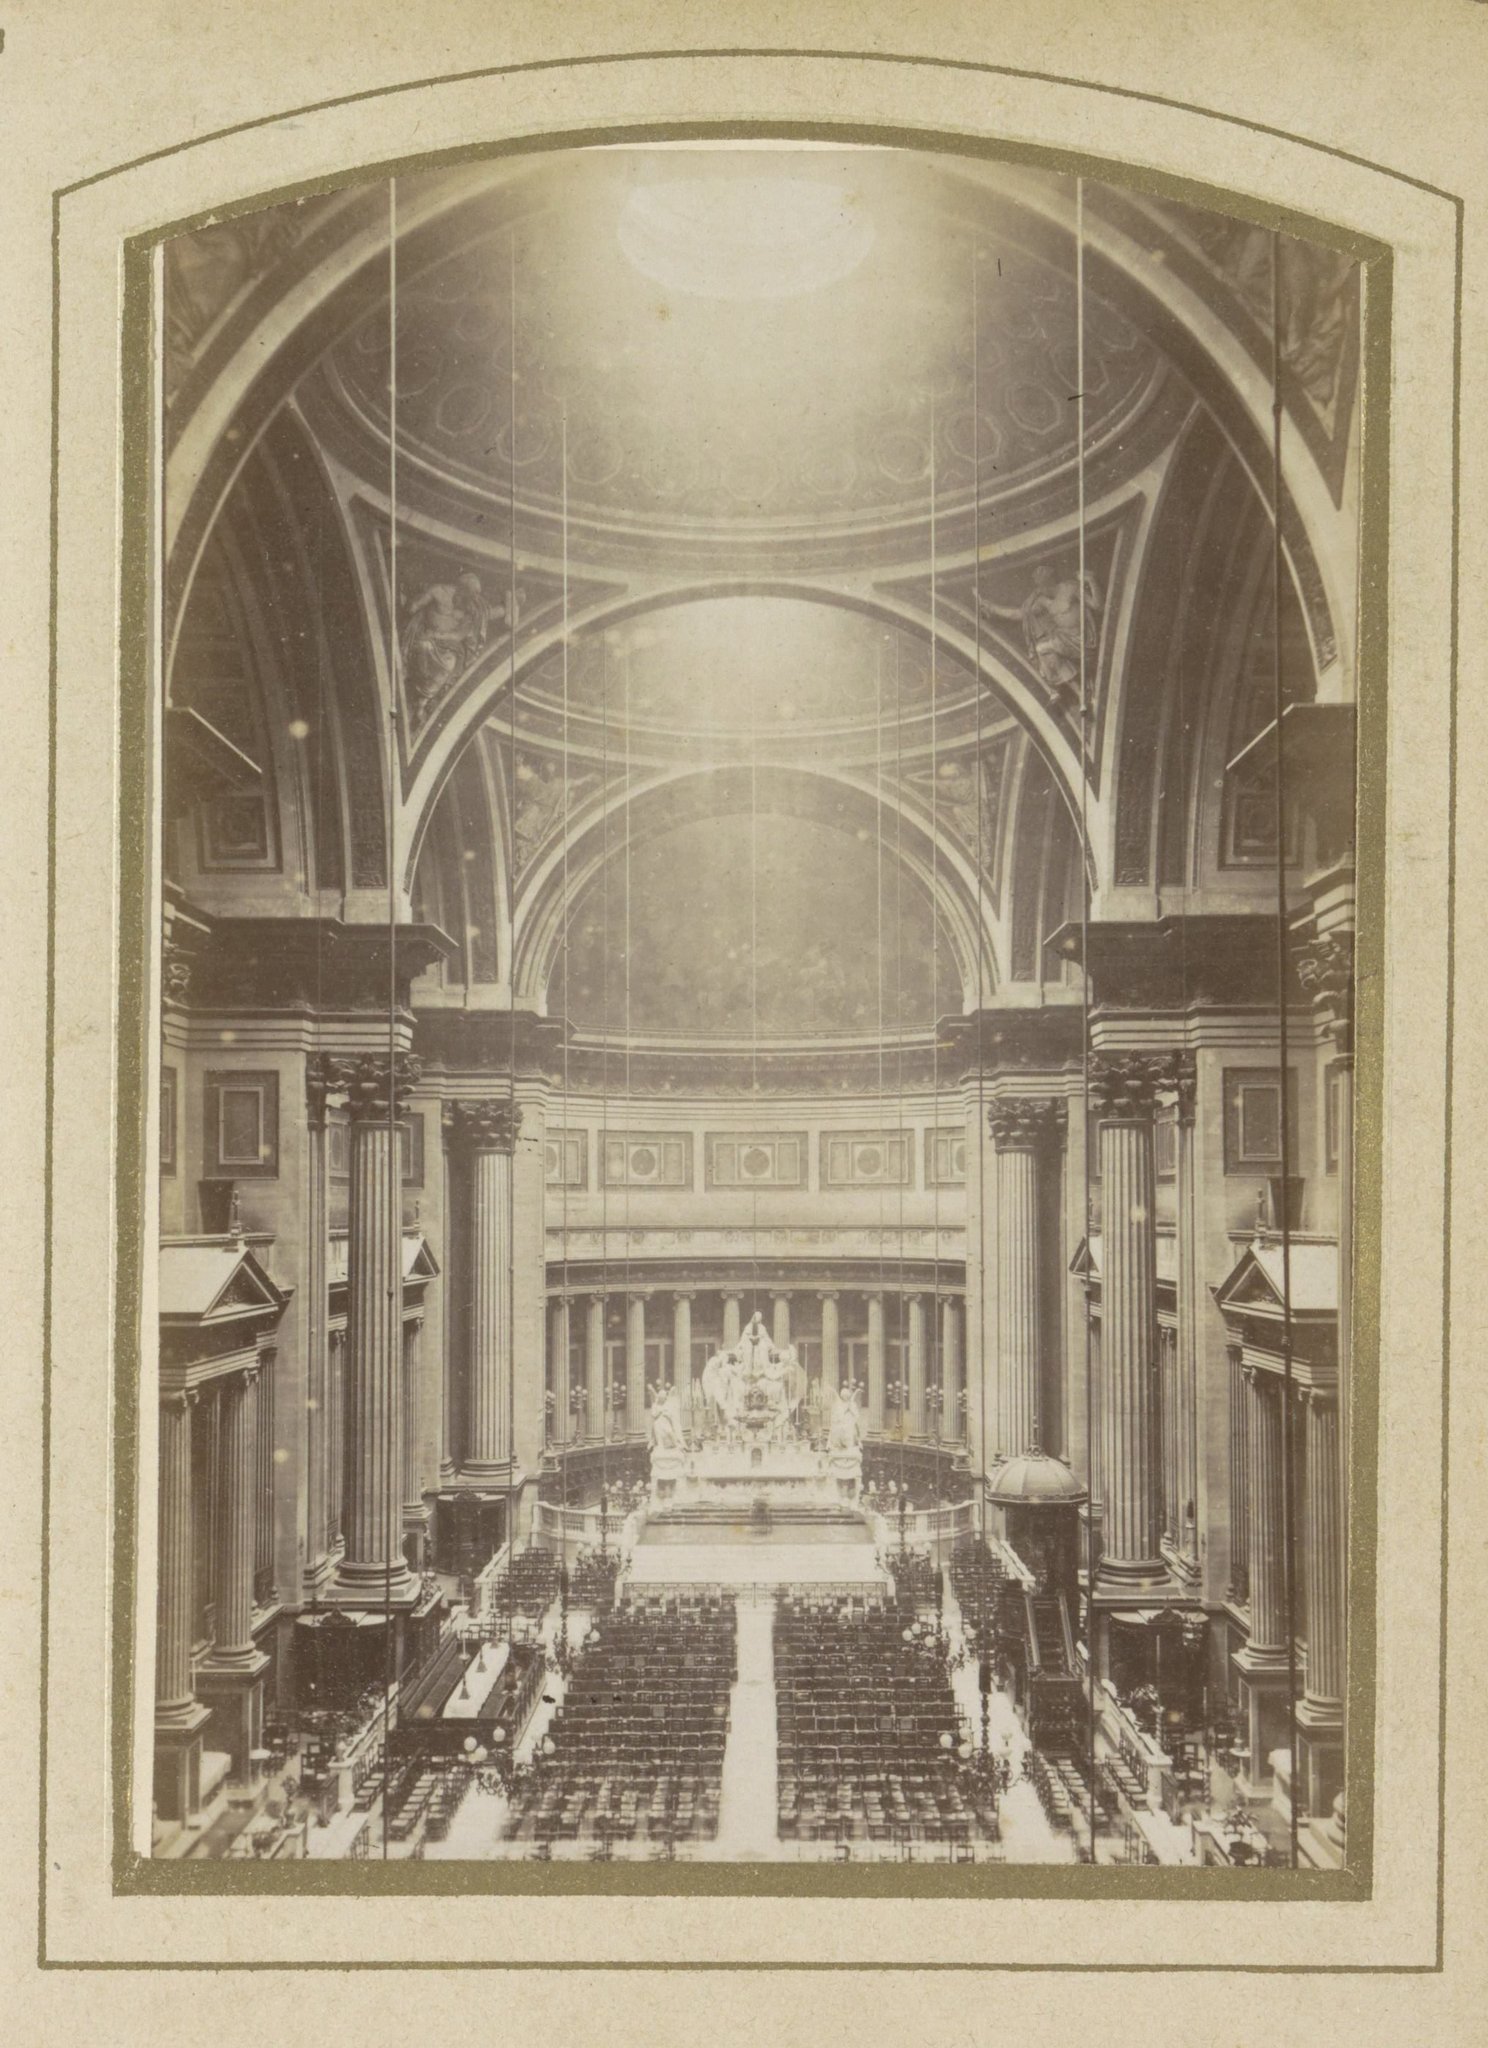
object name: photograph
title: Interieur van de Madeleine in Parijs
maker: Anonymous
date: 1870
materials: cardboard, paper, photographic support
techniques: albumen print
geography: paris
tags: parts of church interior: nave, parts of church interior: choir, paris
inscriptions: inscription: ‘Madeleine’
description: Onderdeel van Fotoalbum met kabinetfoto's van bezienswaardigheden in Parijs.